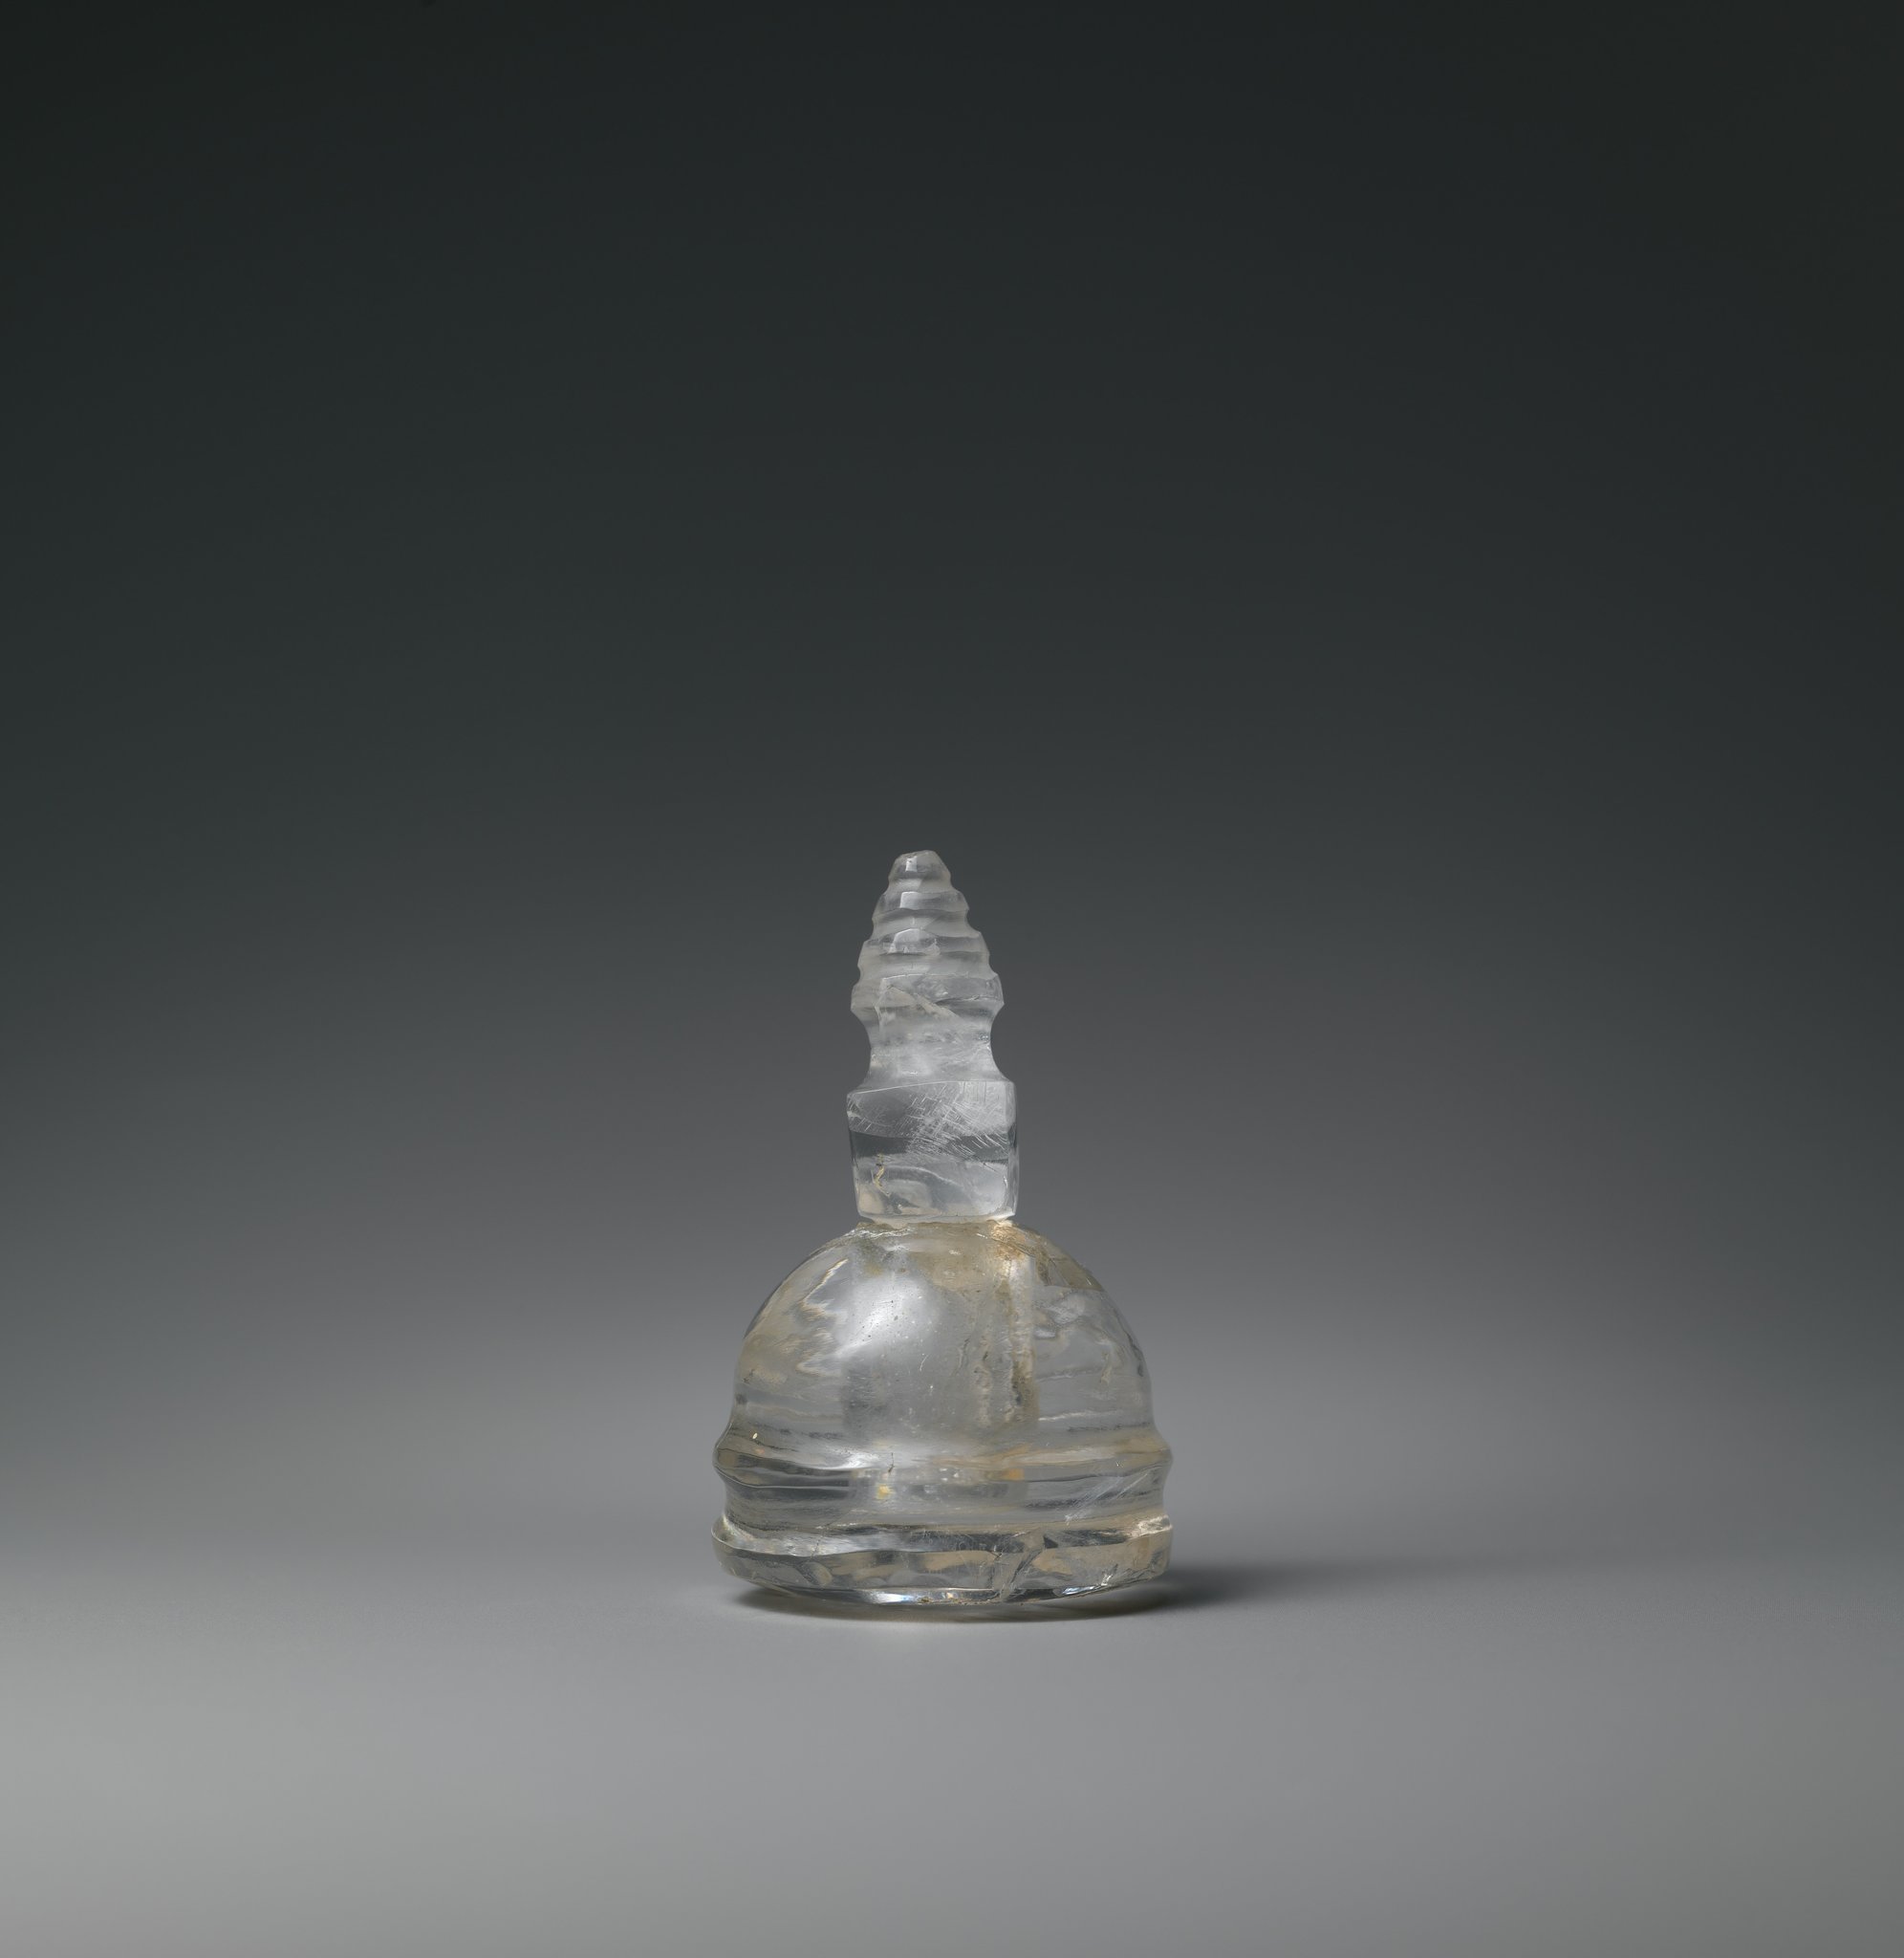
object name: reliquary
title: Reliquary in the shape of a stupa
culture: sri lankan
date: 201-400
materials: quartz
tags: reliquaries